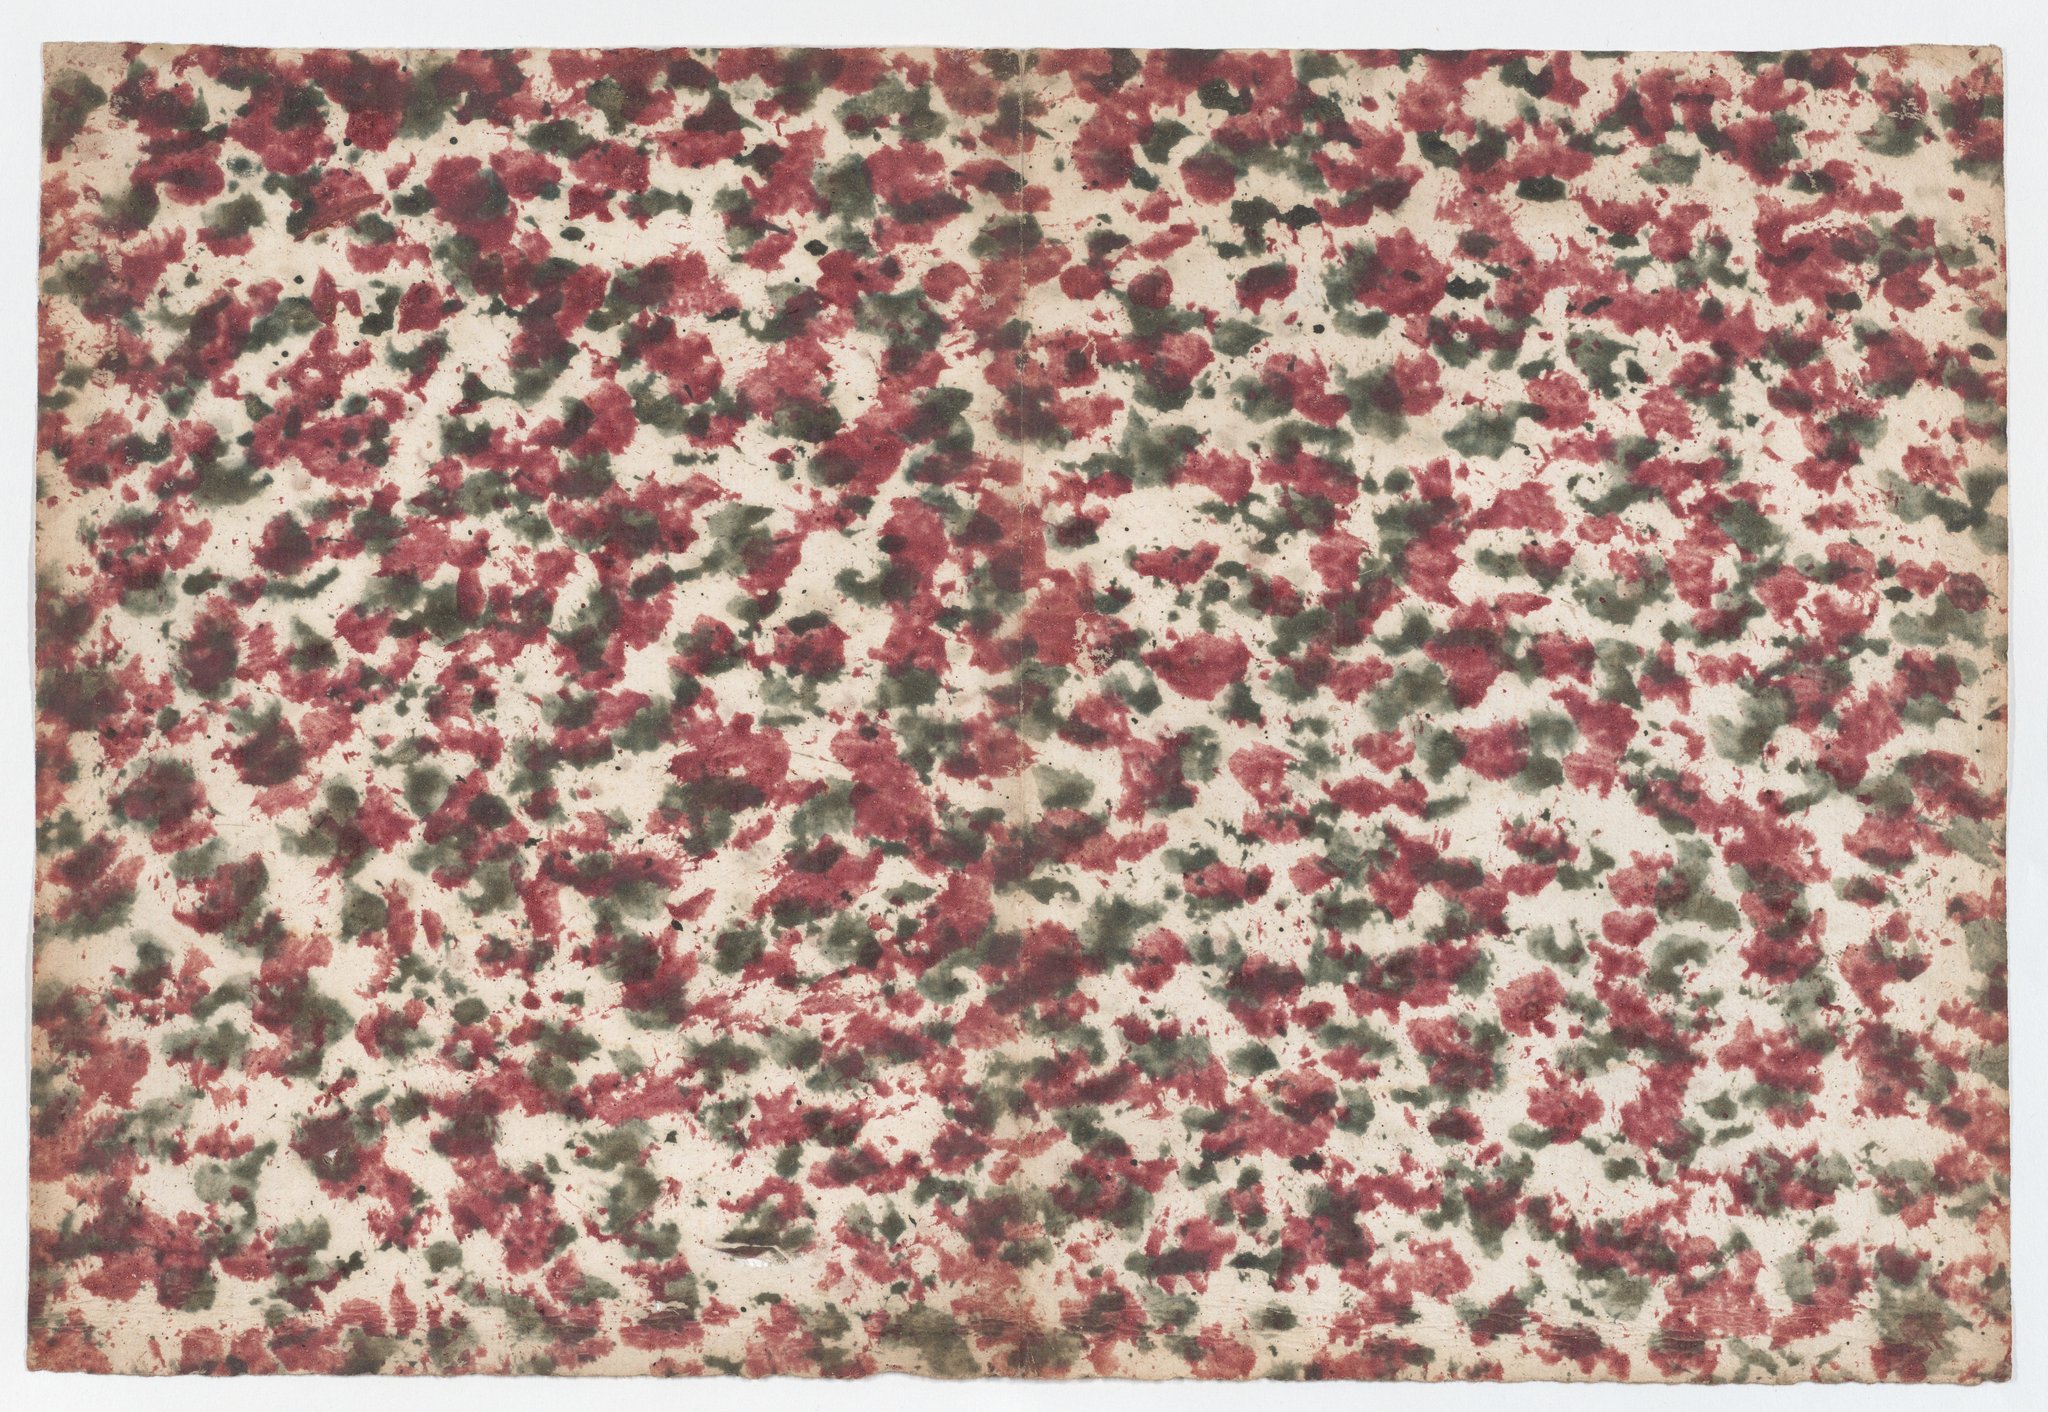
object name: print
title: Sheet with overall green and red splotchy design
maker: Anonymous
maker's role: artist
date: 1801-1900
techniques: relief print